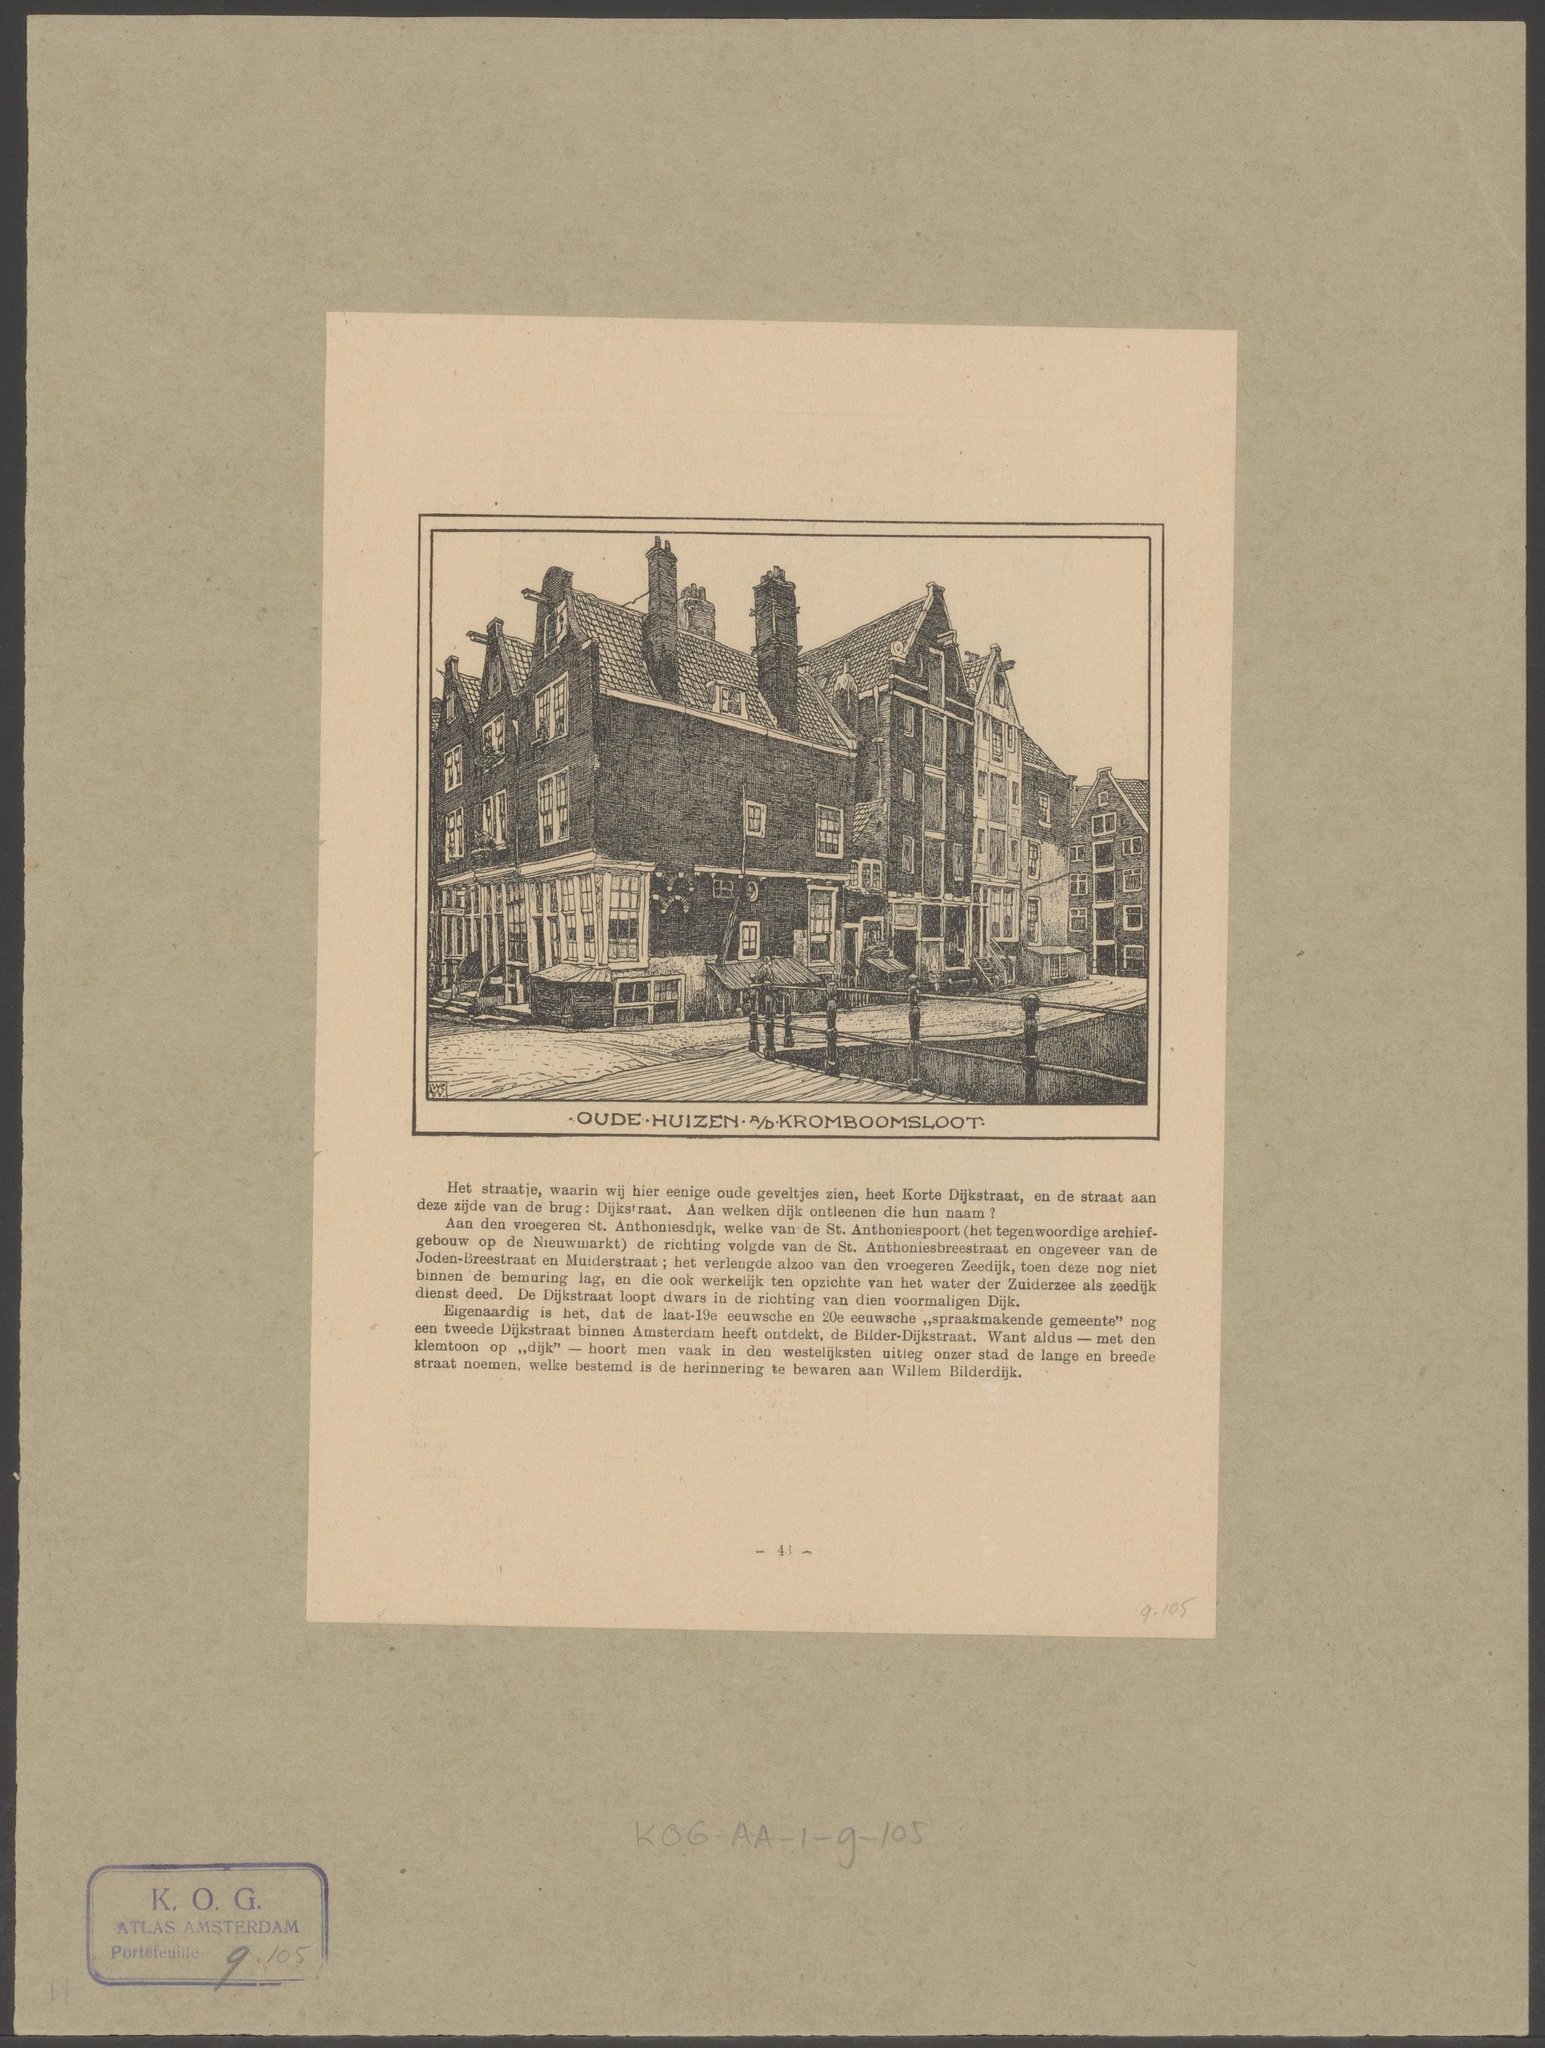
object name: photomechanical print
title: Gezicht op enkele huizen aan de Krom Boomssloot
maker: willem wenckebach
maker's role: designer, draughtsman, painter, print maker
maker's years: 1860-1937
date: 1870-1923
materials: paper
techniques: letterpress printing, line block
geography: amsterdam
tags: city-view in general; 'veduta', canal, the usual house or row of houses, bridge in city across river, canal, etc.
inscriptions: collector's mark: ‘9-105’ Lugt 1641b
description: Onderwerpsrubriek binnen de Atlas Amsterdam: Kadijksplein, Karthuizerkerkhof, Kattegat, Kattenburg, Kapelsteeg O.Z., Enge Kerksteeg, Kerkstraat, Kinkerstraat, Kolk O.Z., Koningsplein, Kromboomsloot [Krom Boomssloot], Kostverlorenkade, Kwakersdwarspad, Kalverstraat, Keizersgracht (v.d. Brouwersgracht – Amstel), Klerensloot (Gedempte), Klimopstraat, Kloveniersburgwal, Kraansluis.